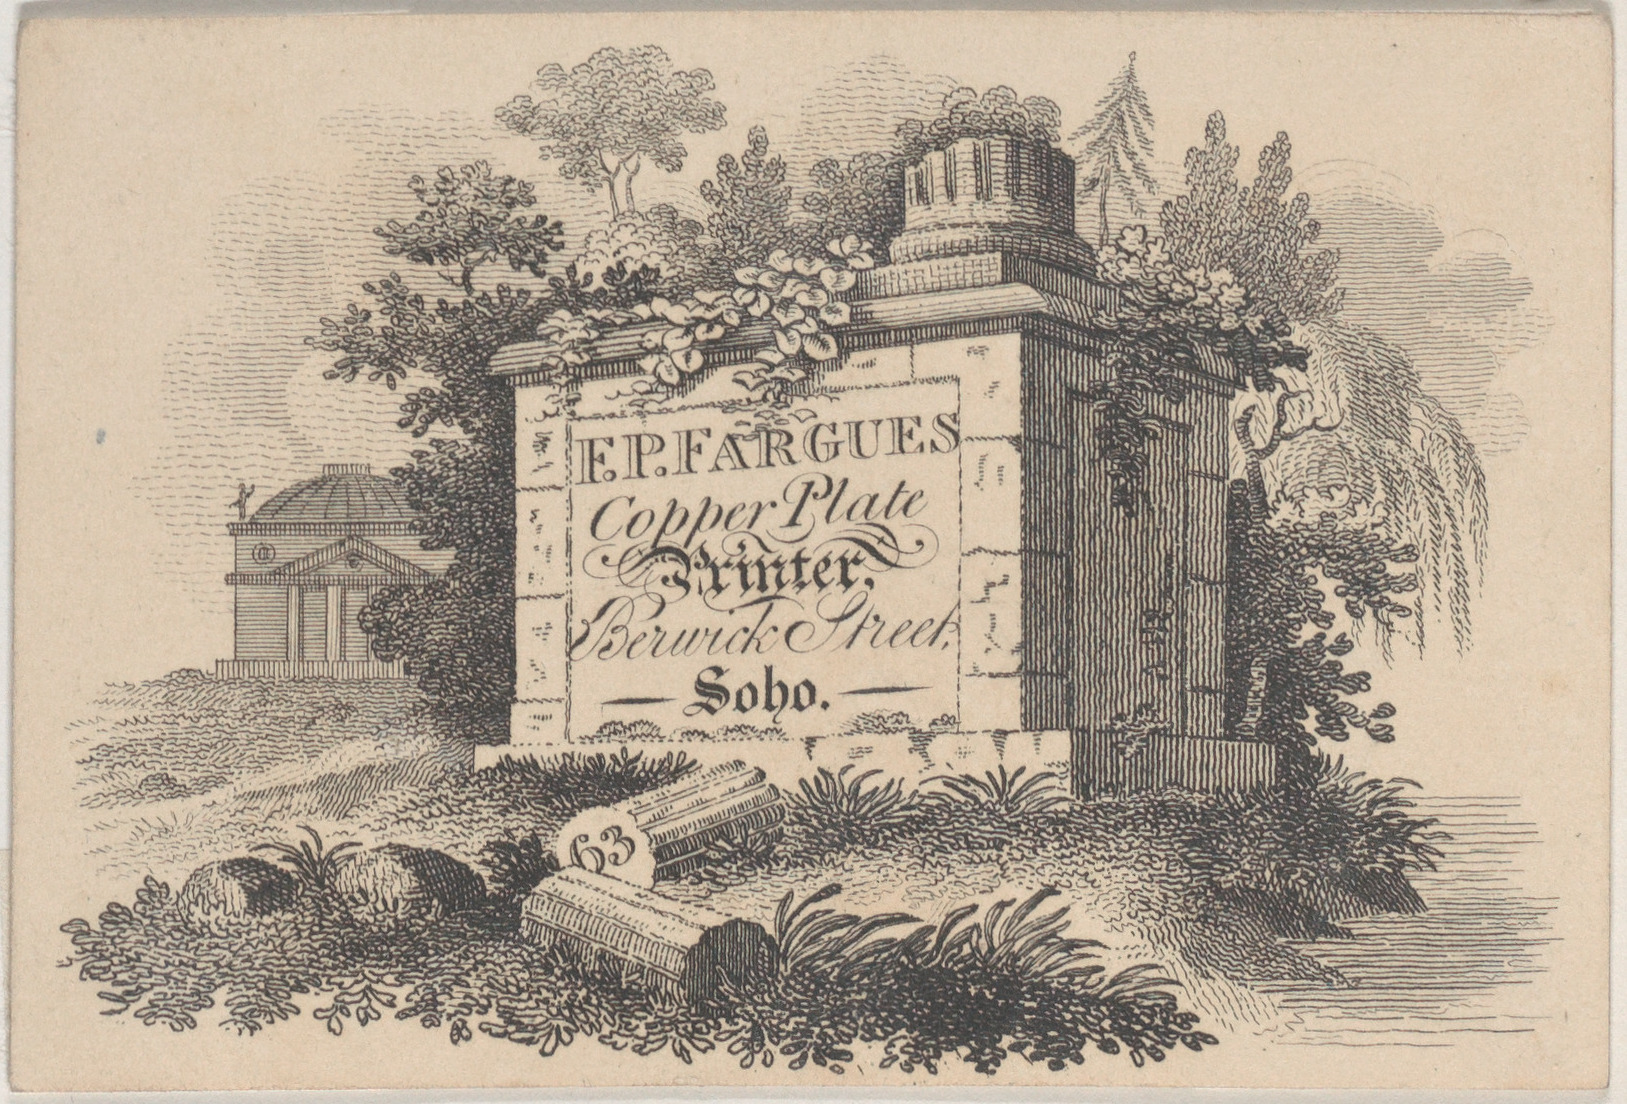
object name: print, trade card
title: Trade Card for F.P. Fargues, Copper Plate Printer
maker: anonymous, british, 19th century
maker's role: artist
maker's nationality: british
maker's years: 1800-1900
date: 1801-1900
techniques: engraving